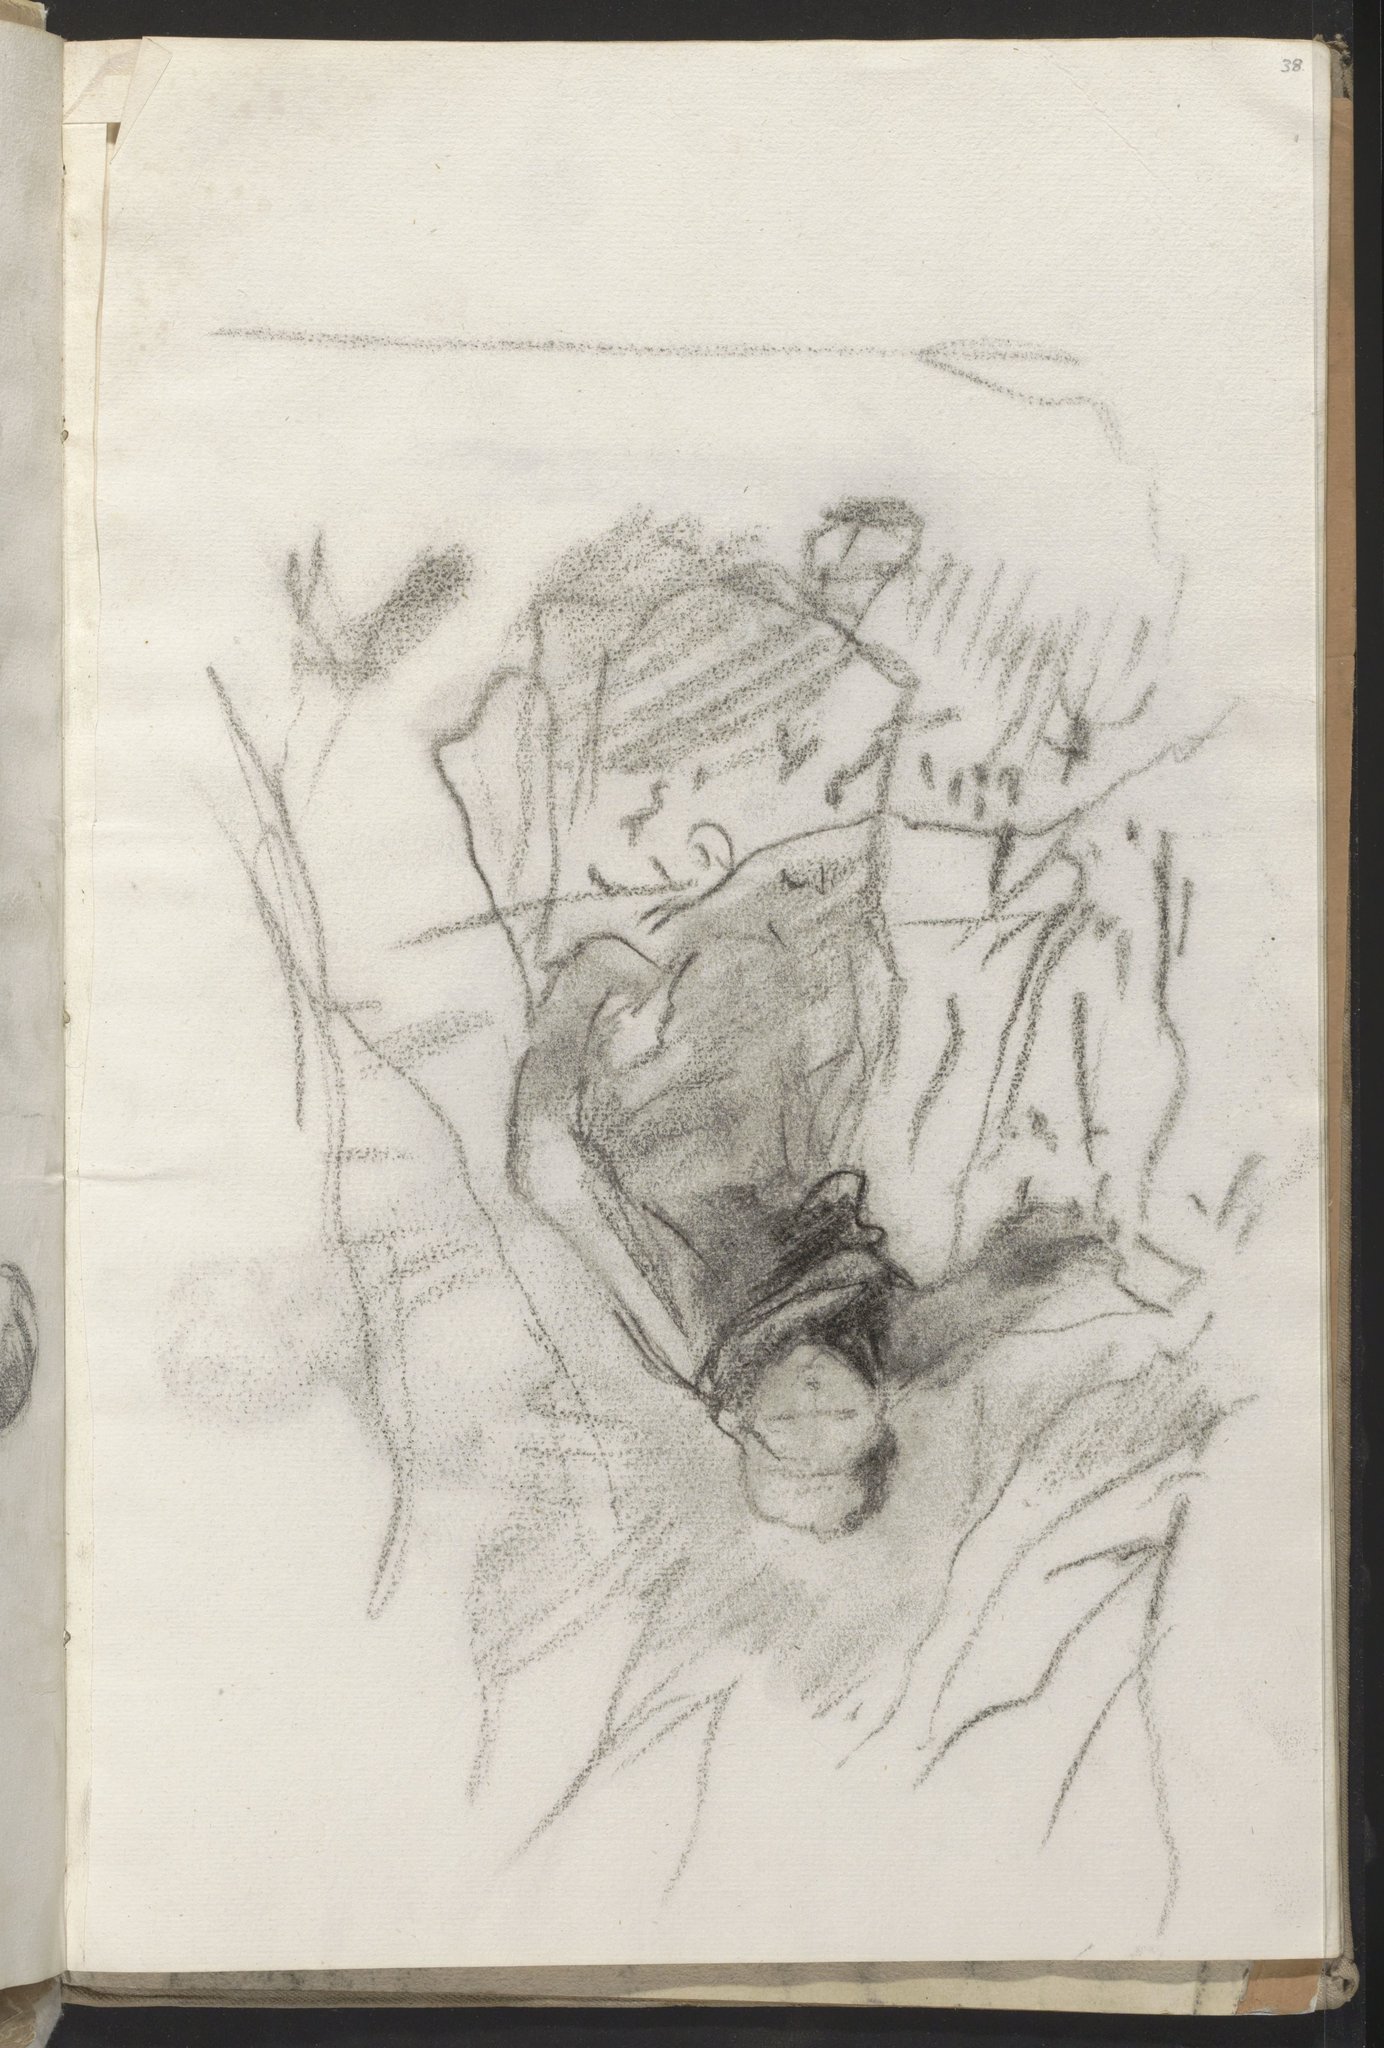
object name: sketchbook leaf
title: Jonge vrouw die zich een weg baant tussen kale bomen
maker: albert neuhuys (1844-1914)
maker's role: draughtsman, painter, print maker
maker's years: 1844-1914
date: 1854-1914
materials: charcoal, paper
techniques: stumping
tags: trees, adult woman, walking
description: Blad 38 recto uit een schetsboek met 53 bladen.